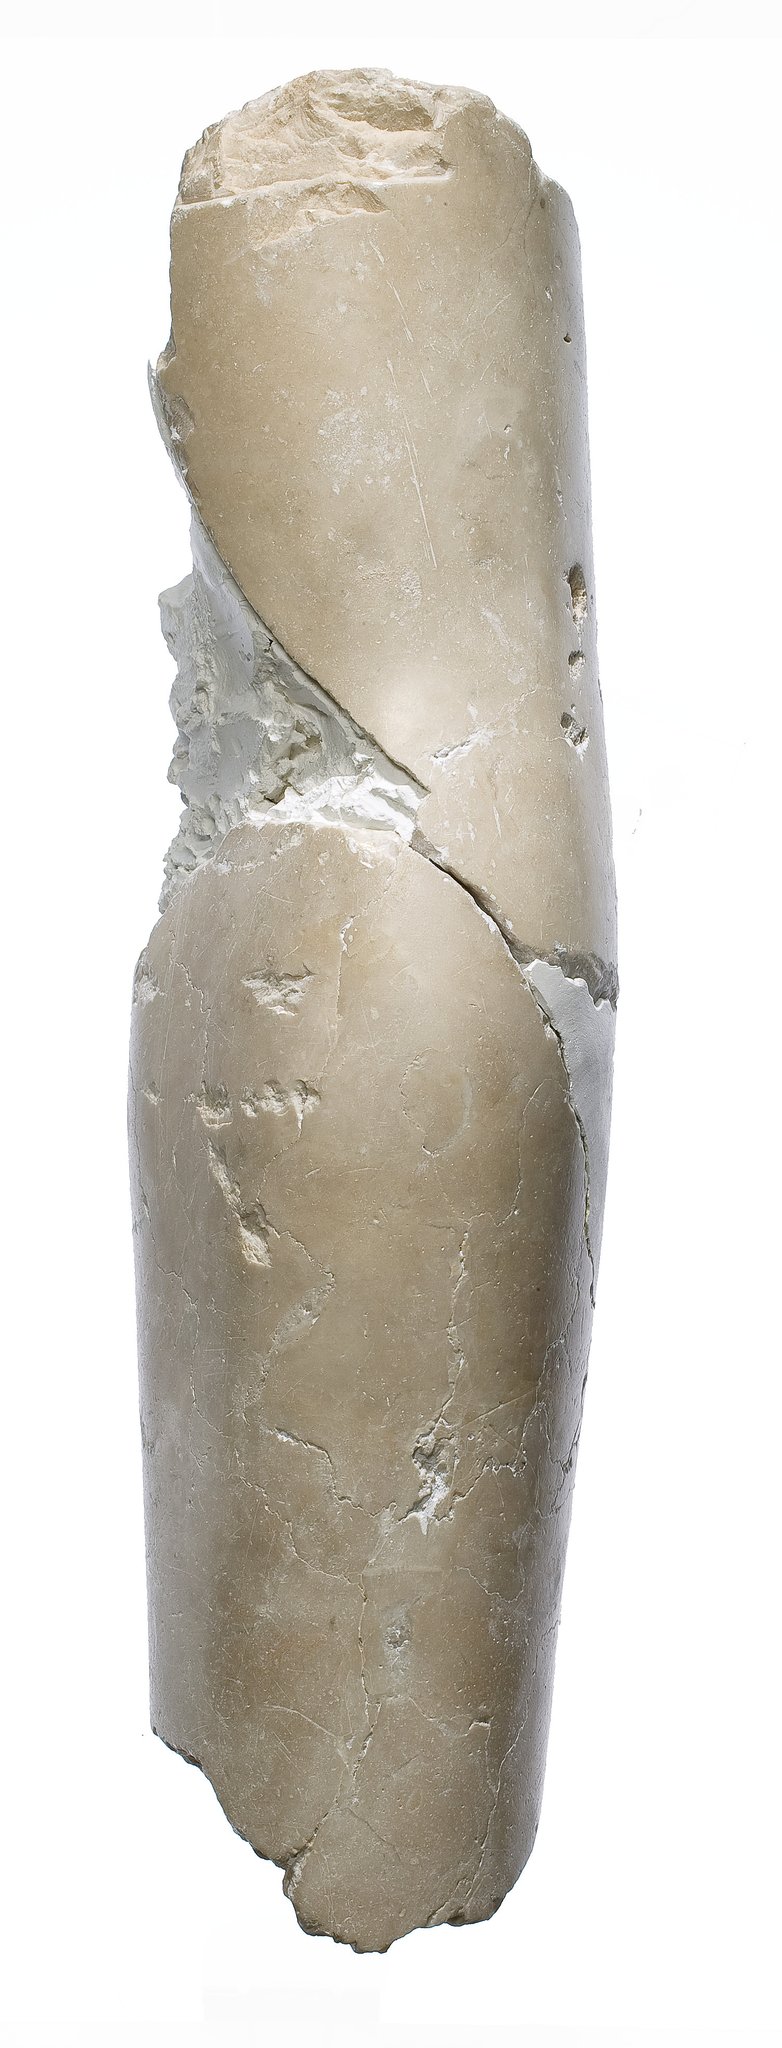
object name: left arm, aten cartouche trace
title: Left arm with Aten cartouche traces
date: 1353-1336 BCE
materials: limestone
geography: egypt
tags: hands